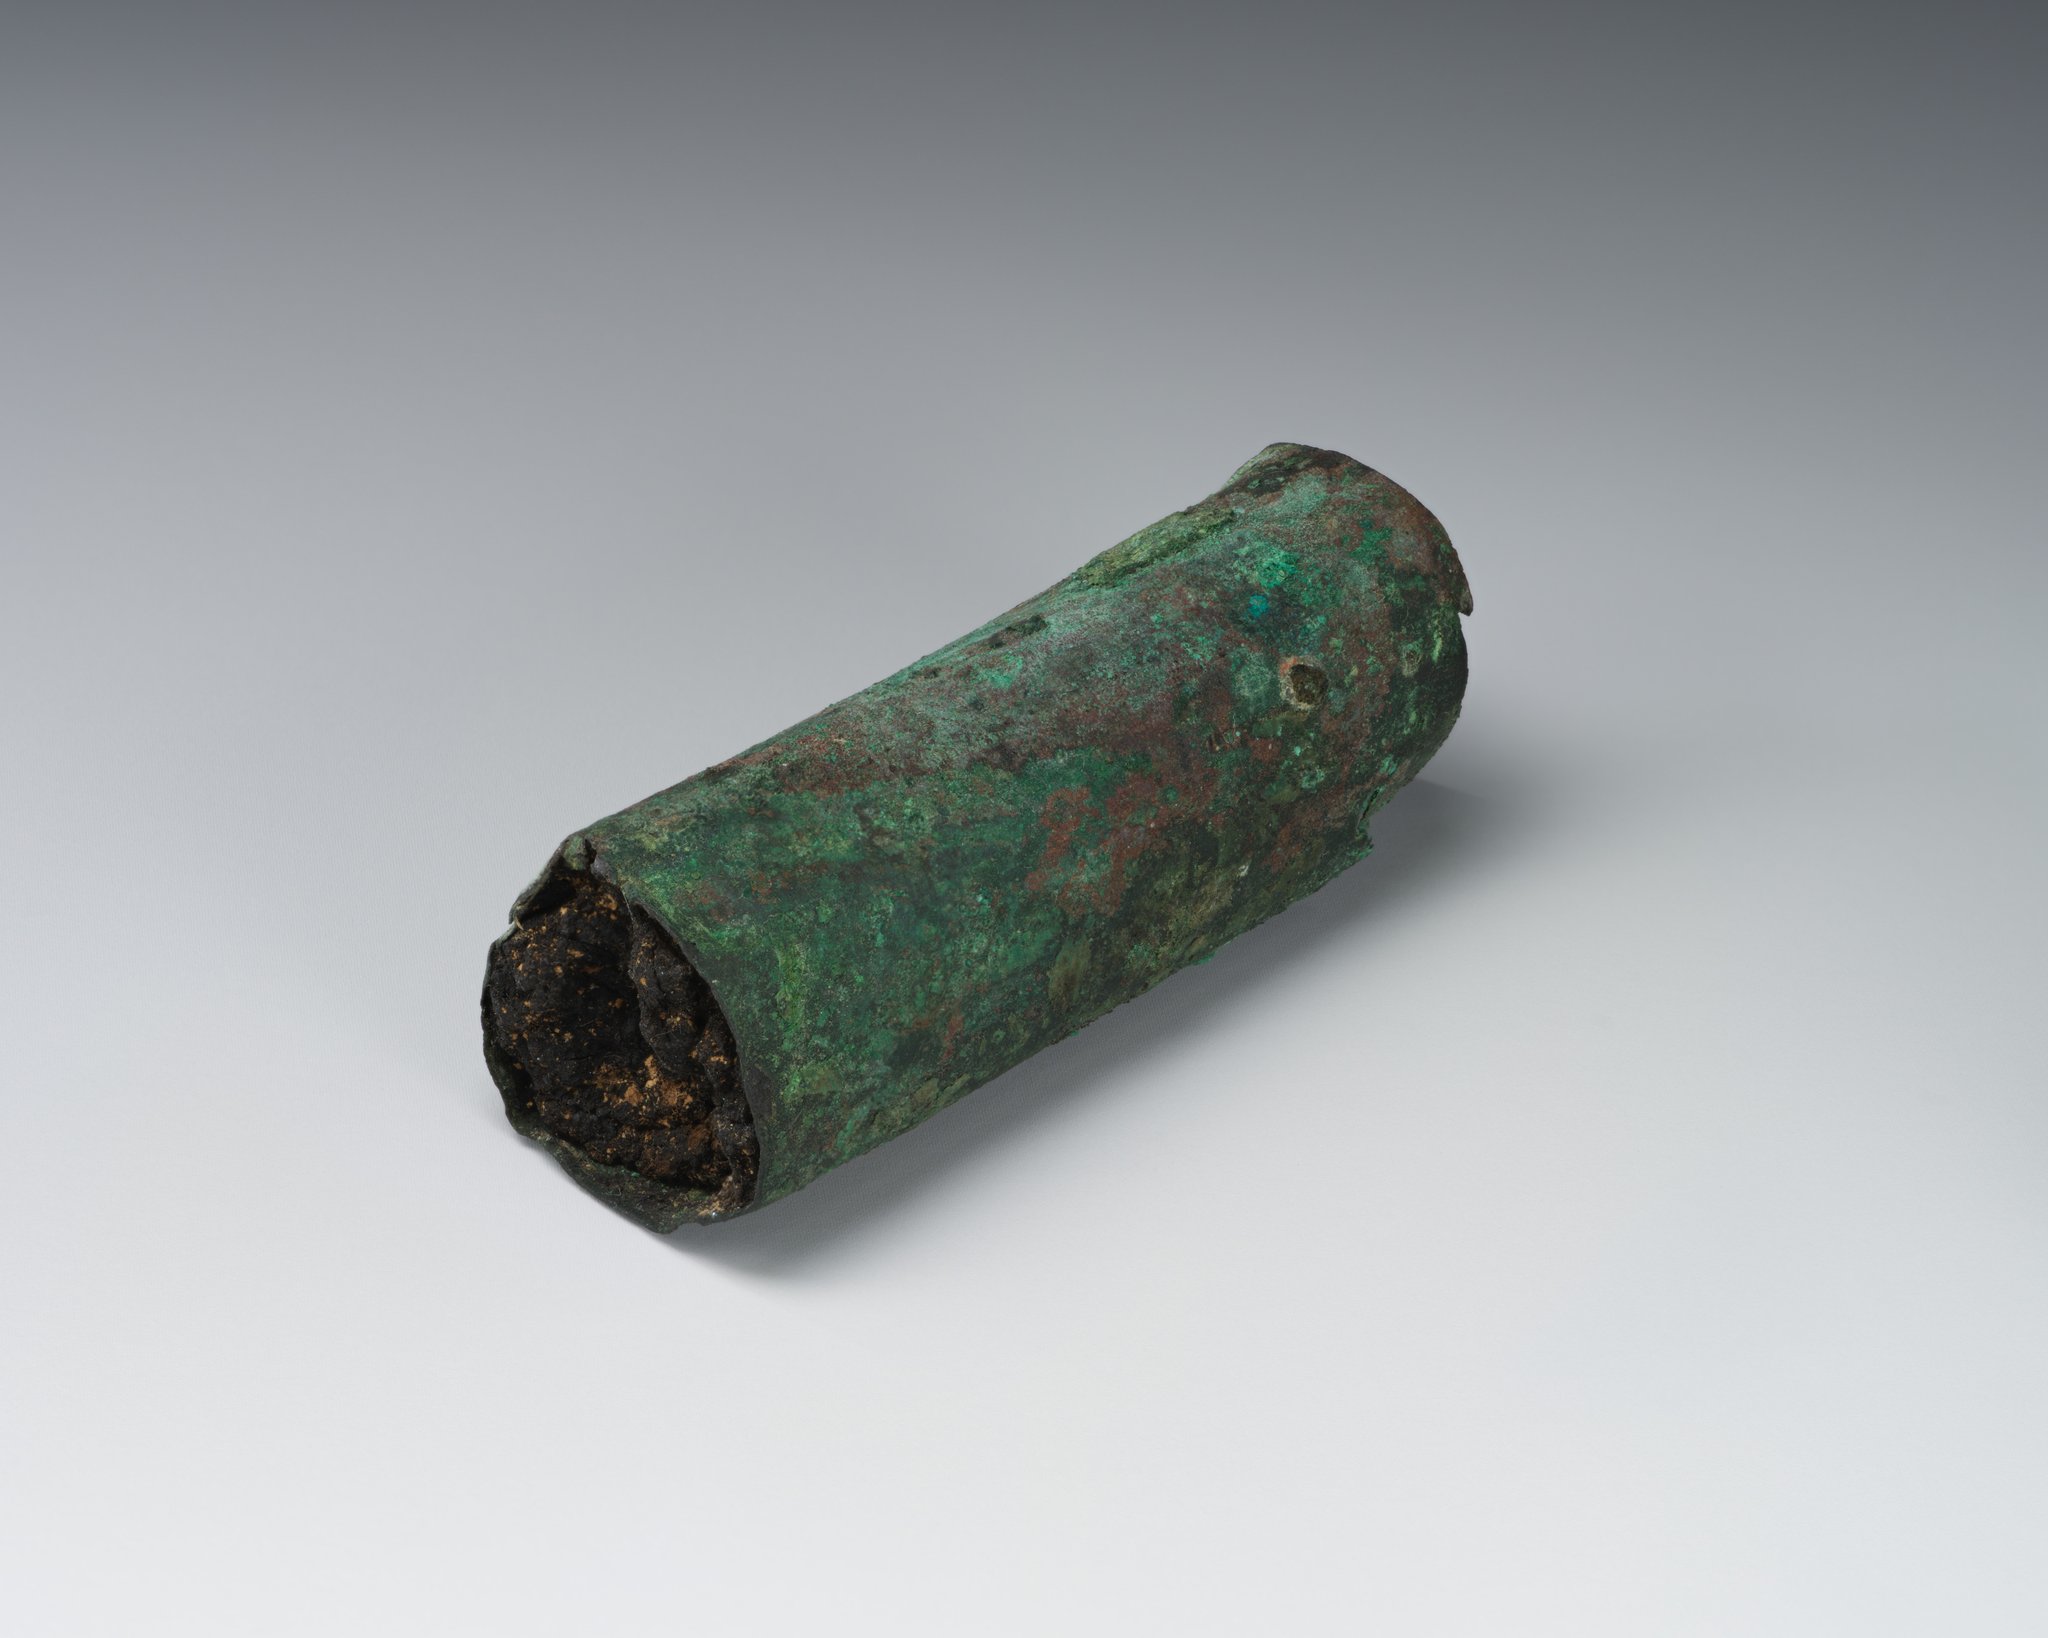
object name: amulet case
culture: sasanian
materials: copper, patina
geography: mesopotamia